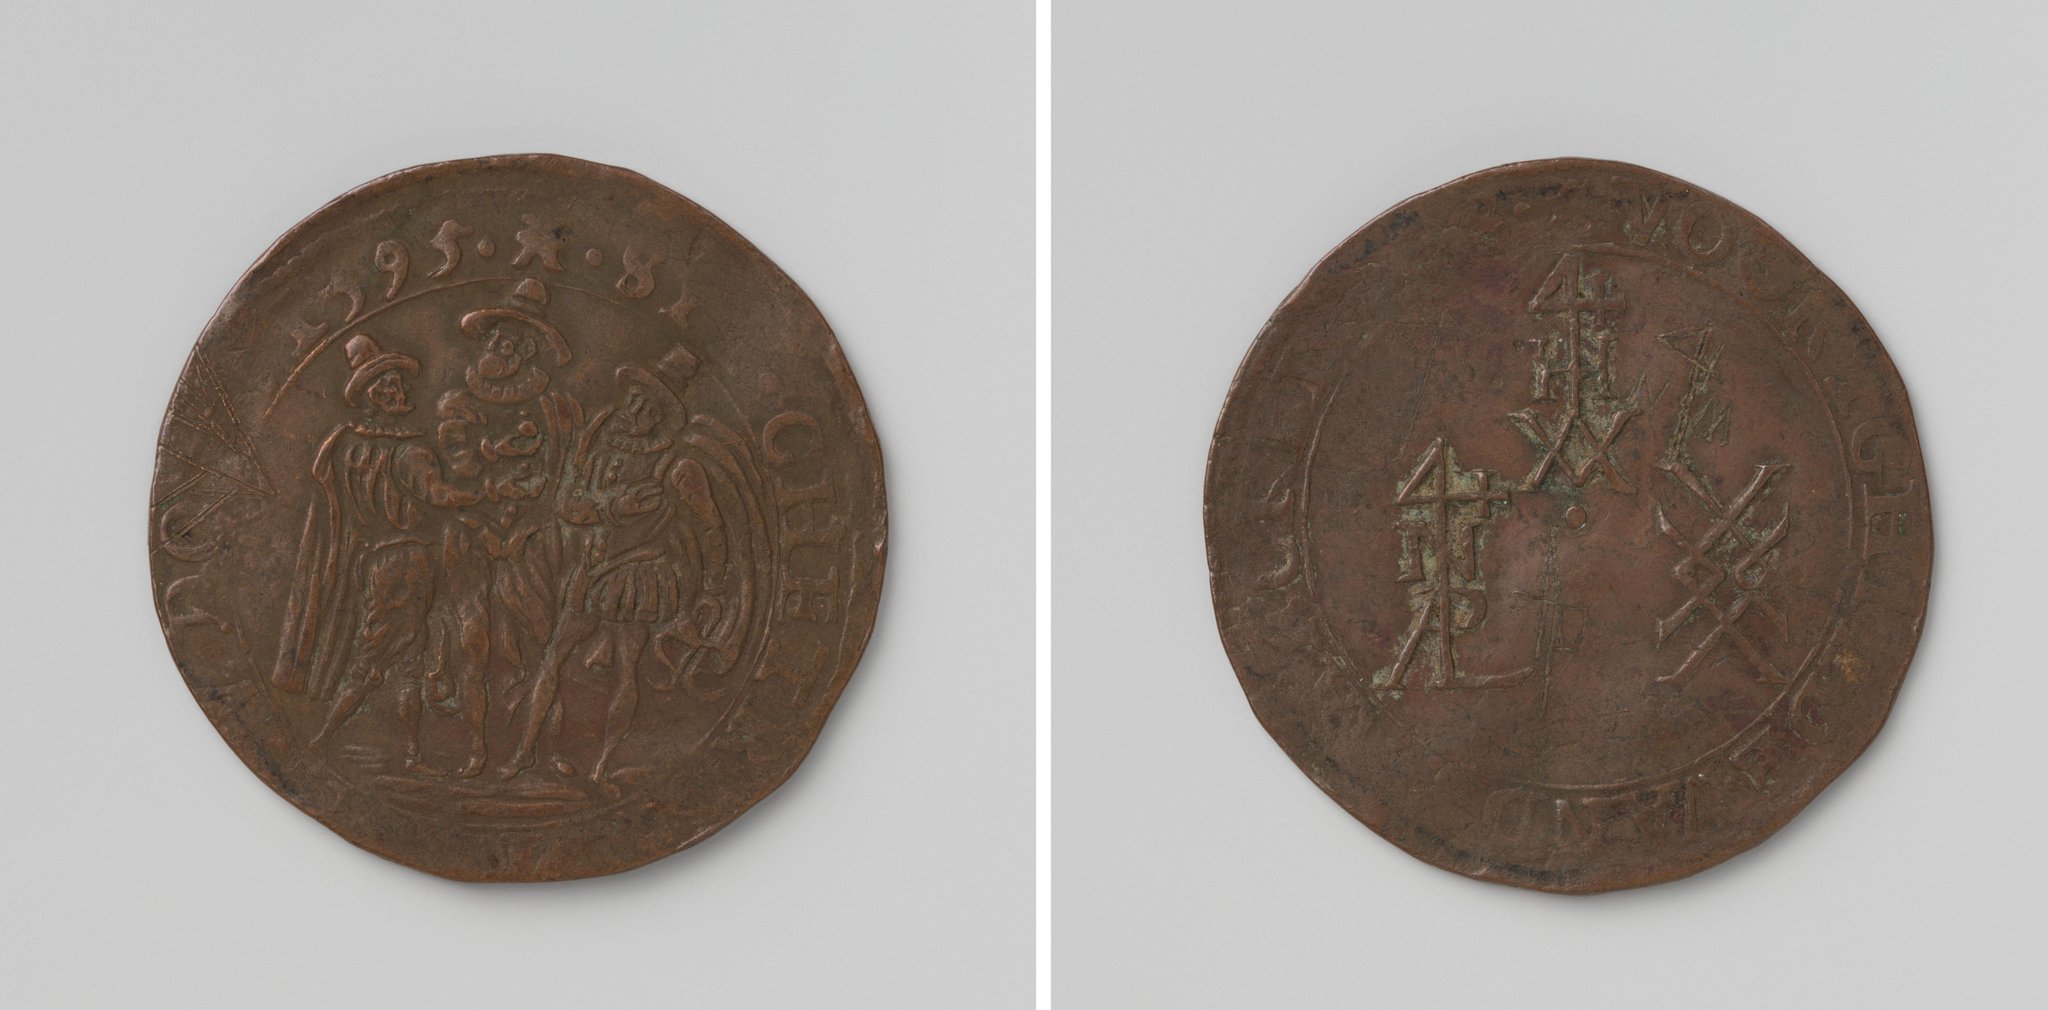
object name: medal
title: Makelaarsgilde van Middelburg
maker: Anonymous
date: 1595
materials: copper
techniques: striking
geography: middelburg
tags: middelburg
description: Koperen penning. Voorzijde: drie mannen die met elkaar staan te praten binnen omschrift. Keerzijde: drie huismerken; gildenummer daartussen is uitgekrast